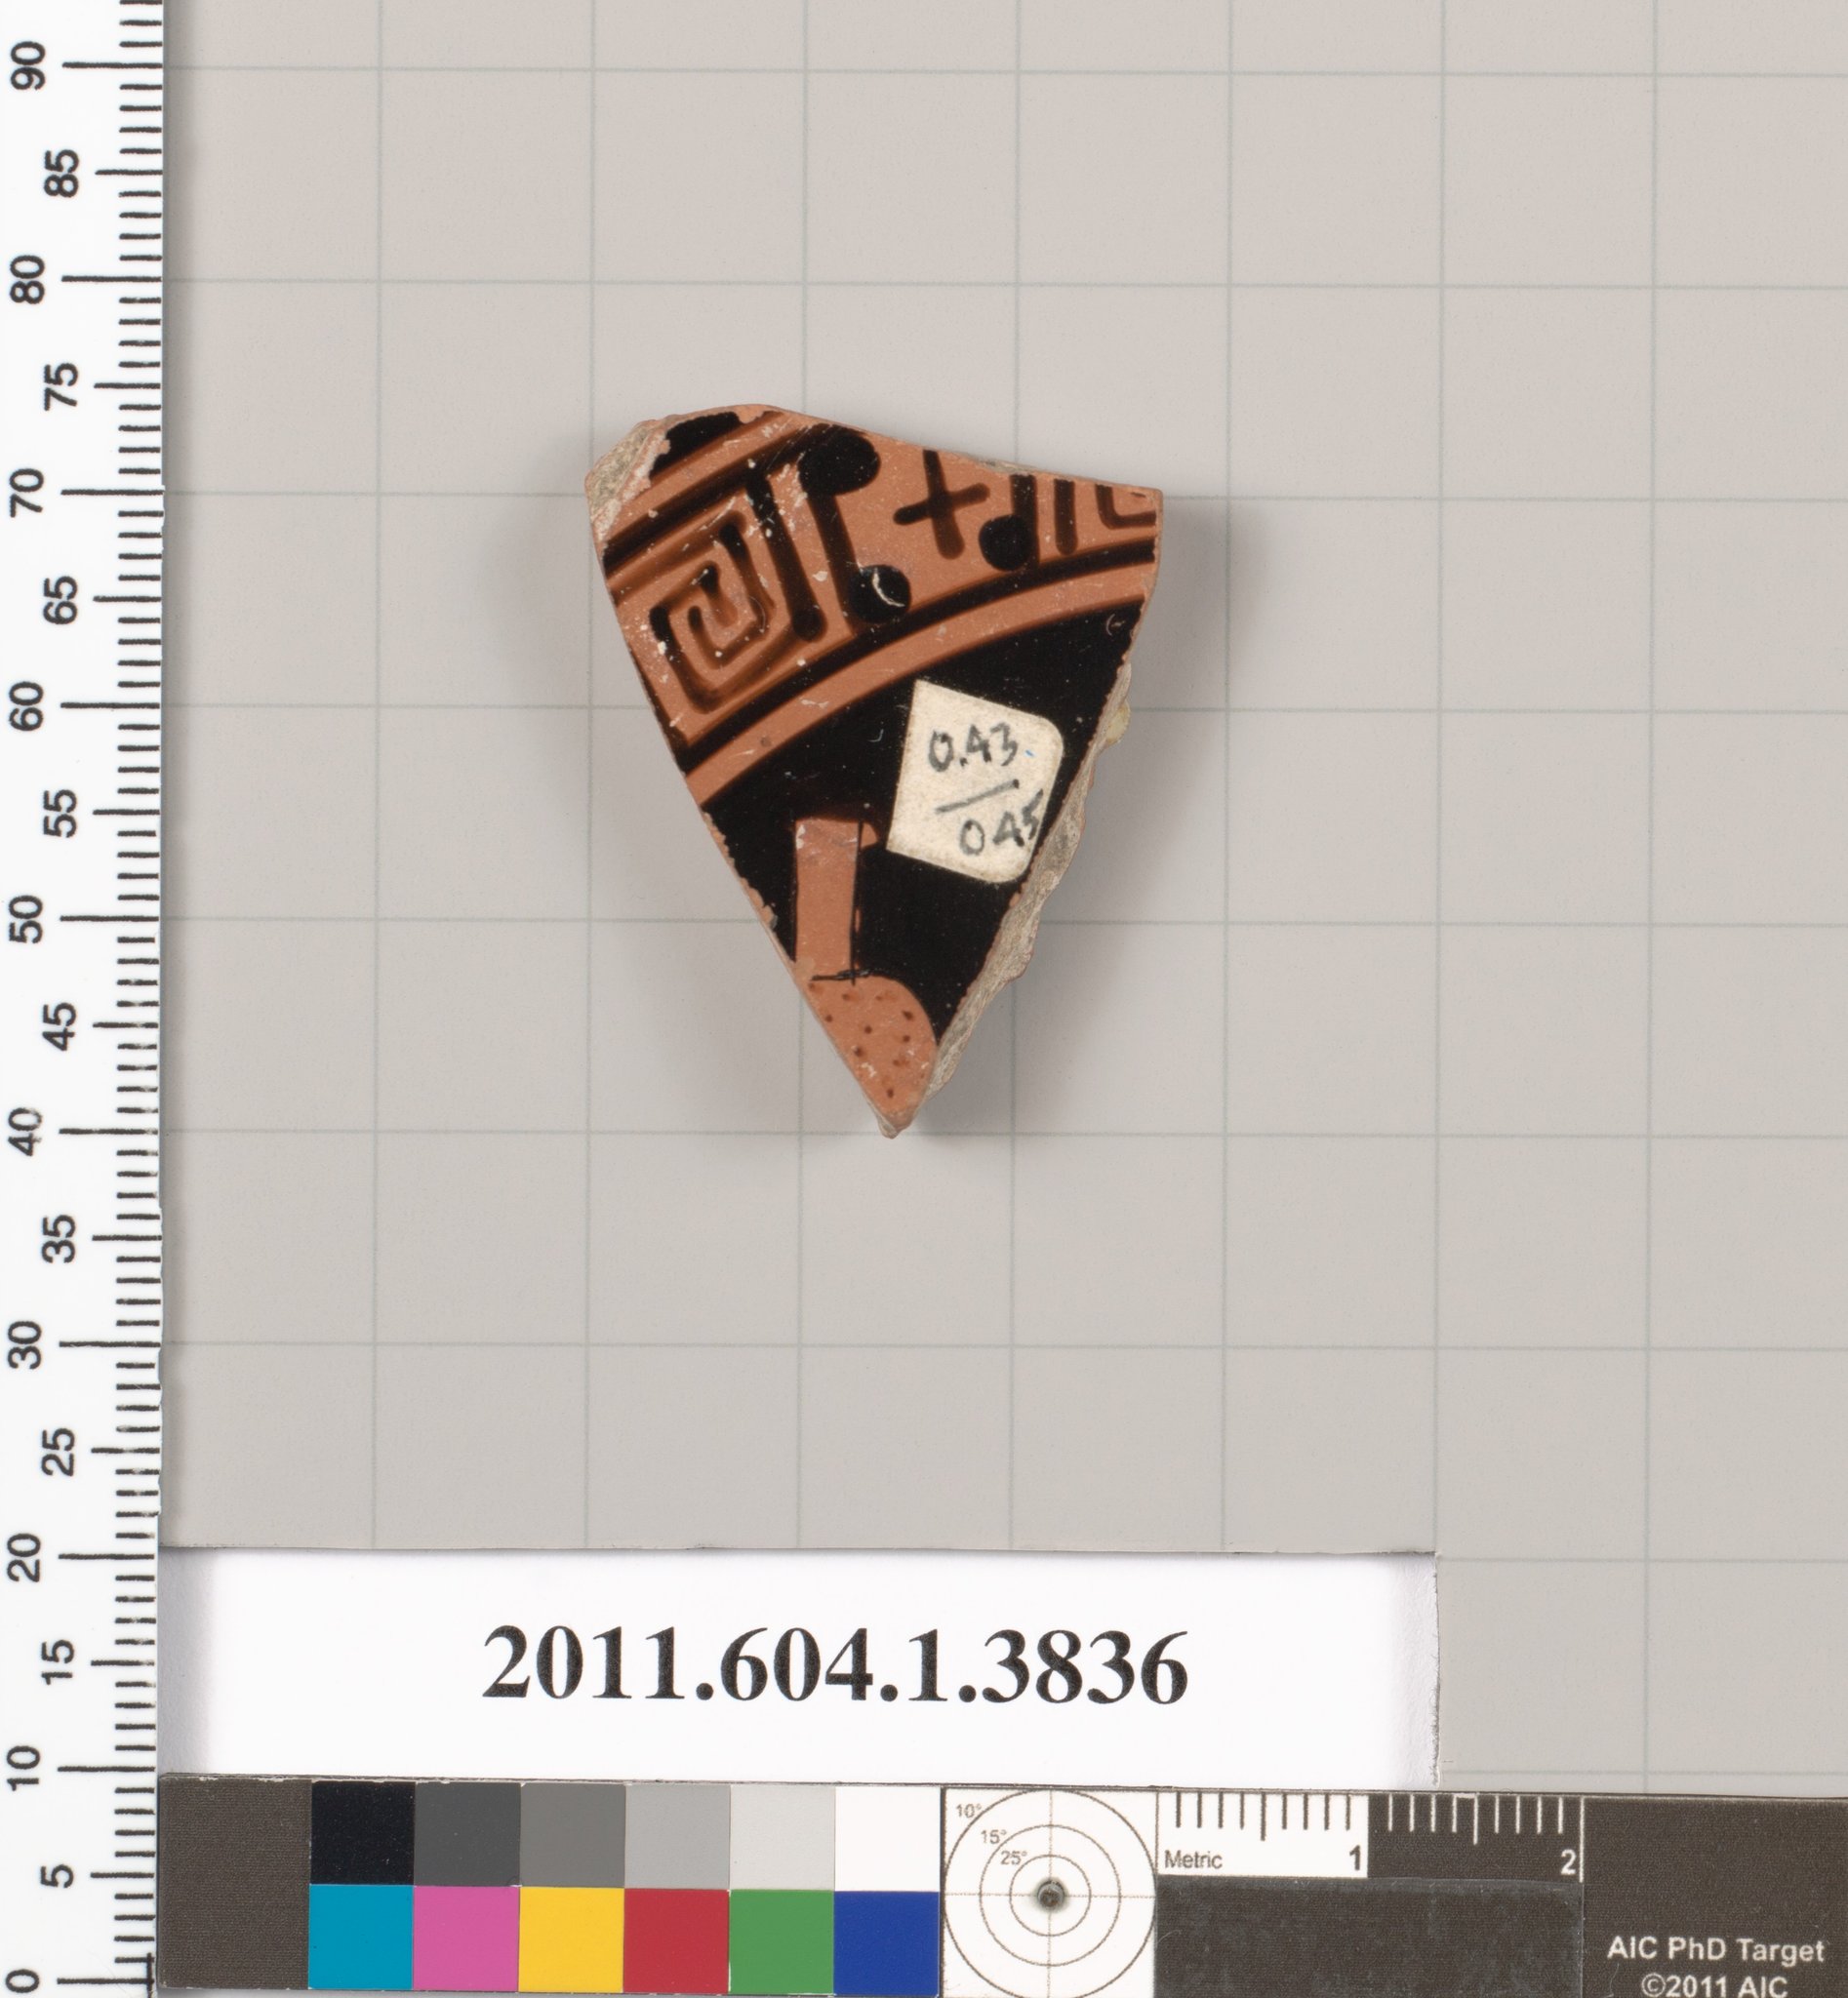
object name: kylix fragment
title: Terracotta fragment of a kylix (drinking cup)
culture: greek, attic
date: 490-470 BCE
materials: terracotta